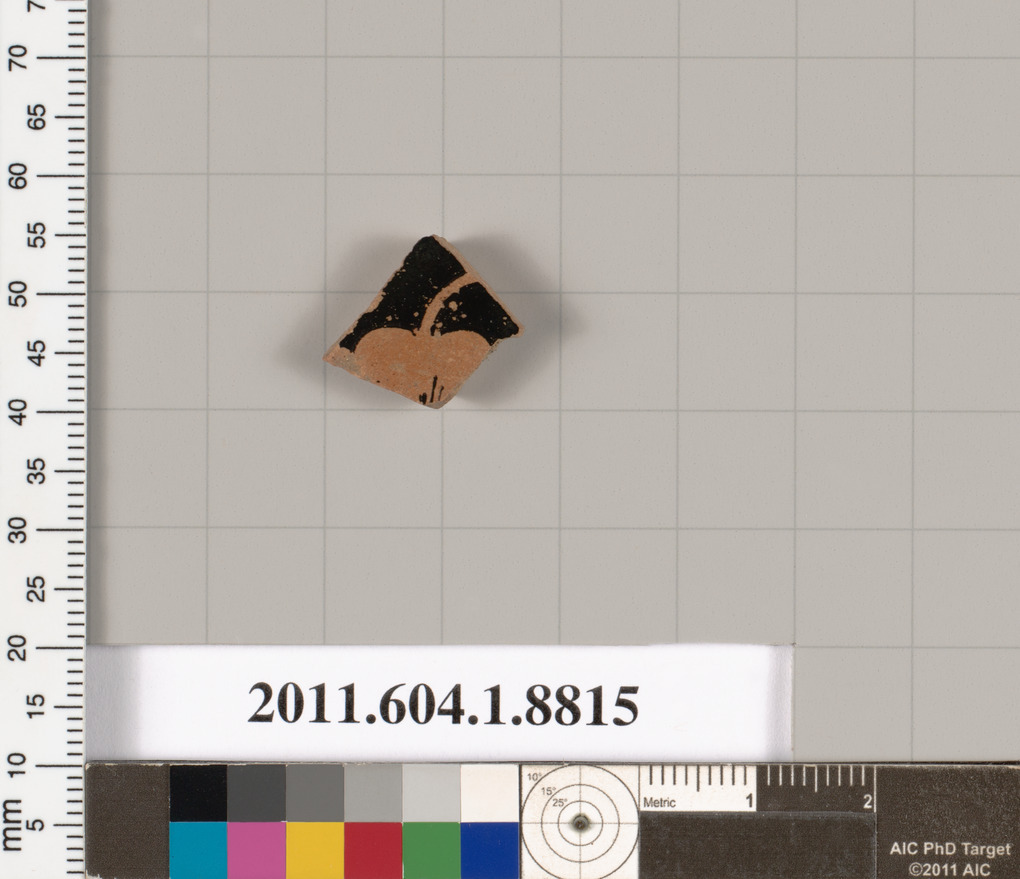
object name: kylix fragment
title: Terracotta fragment of a kylix (cup)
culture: greek, attic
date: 480-470 BCE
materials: terracotta